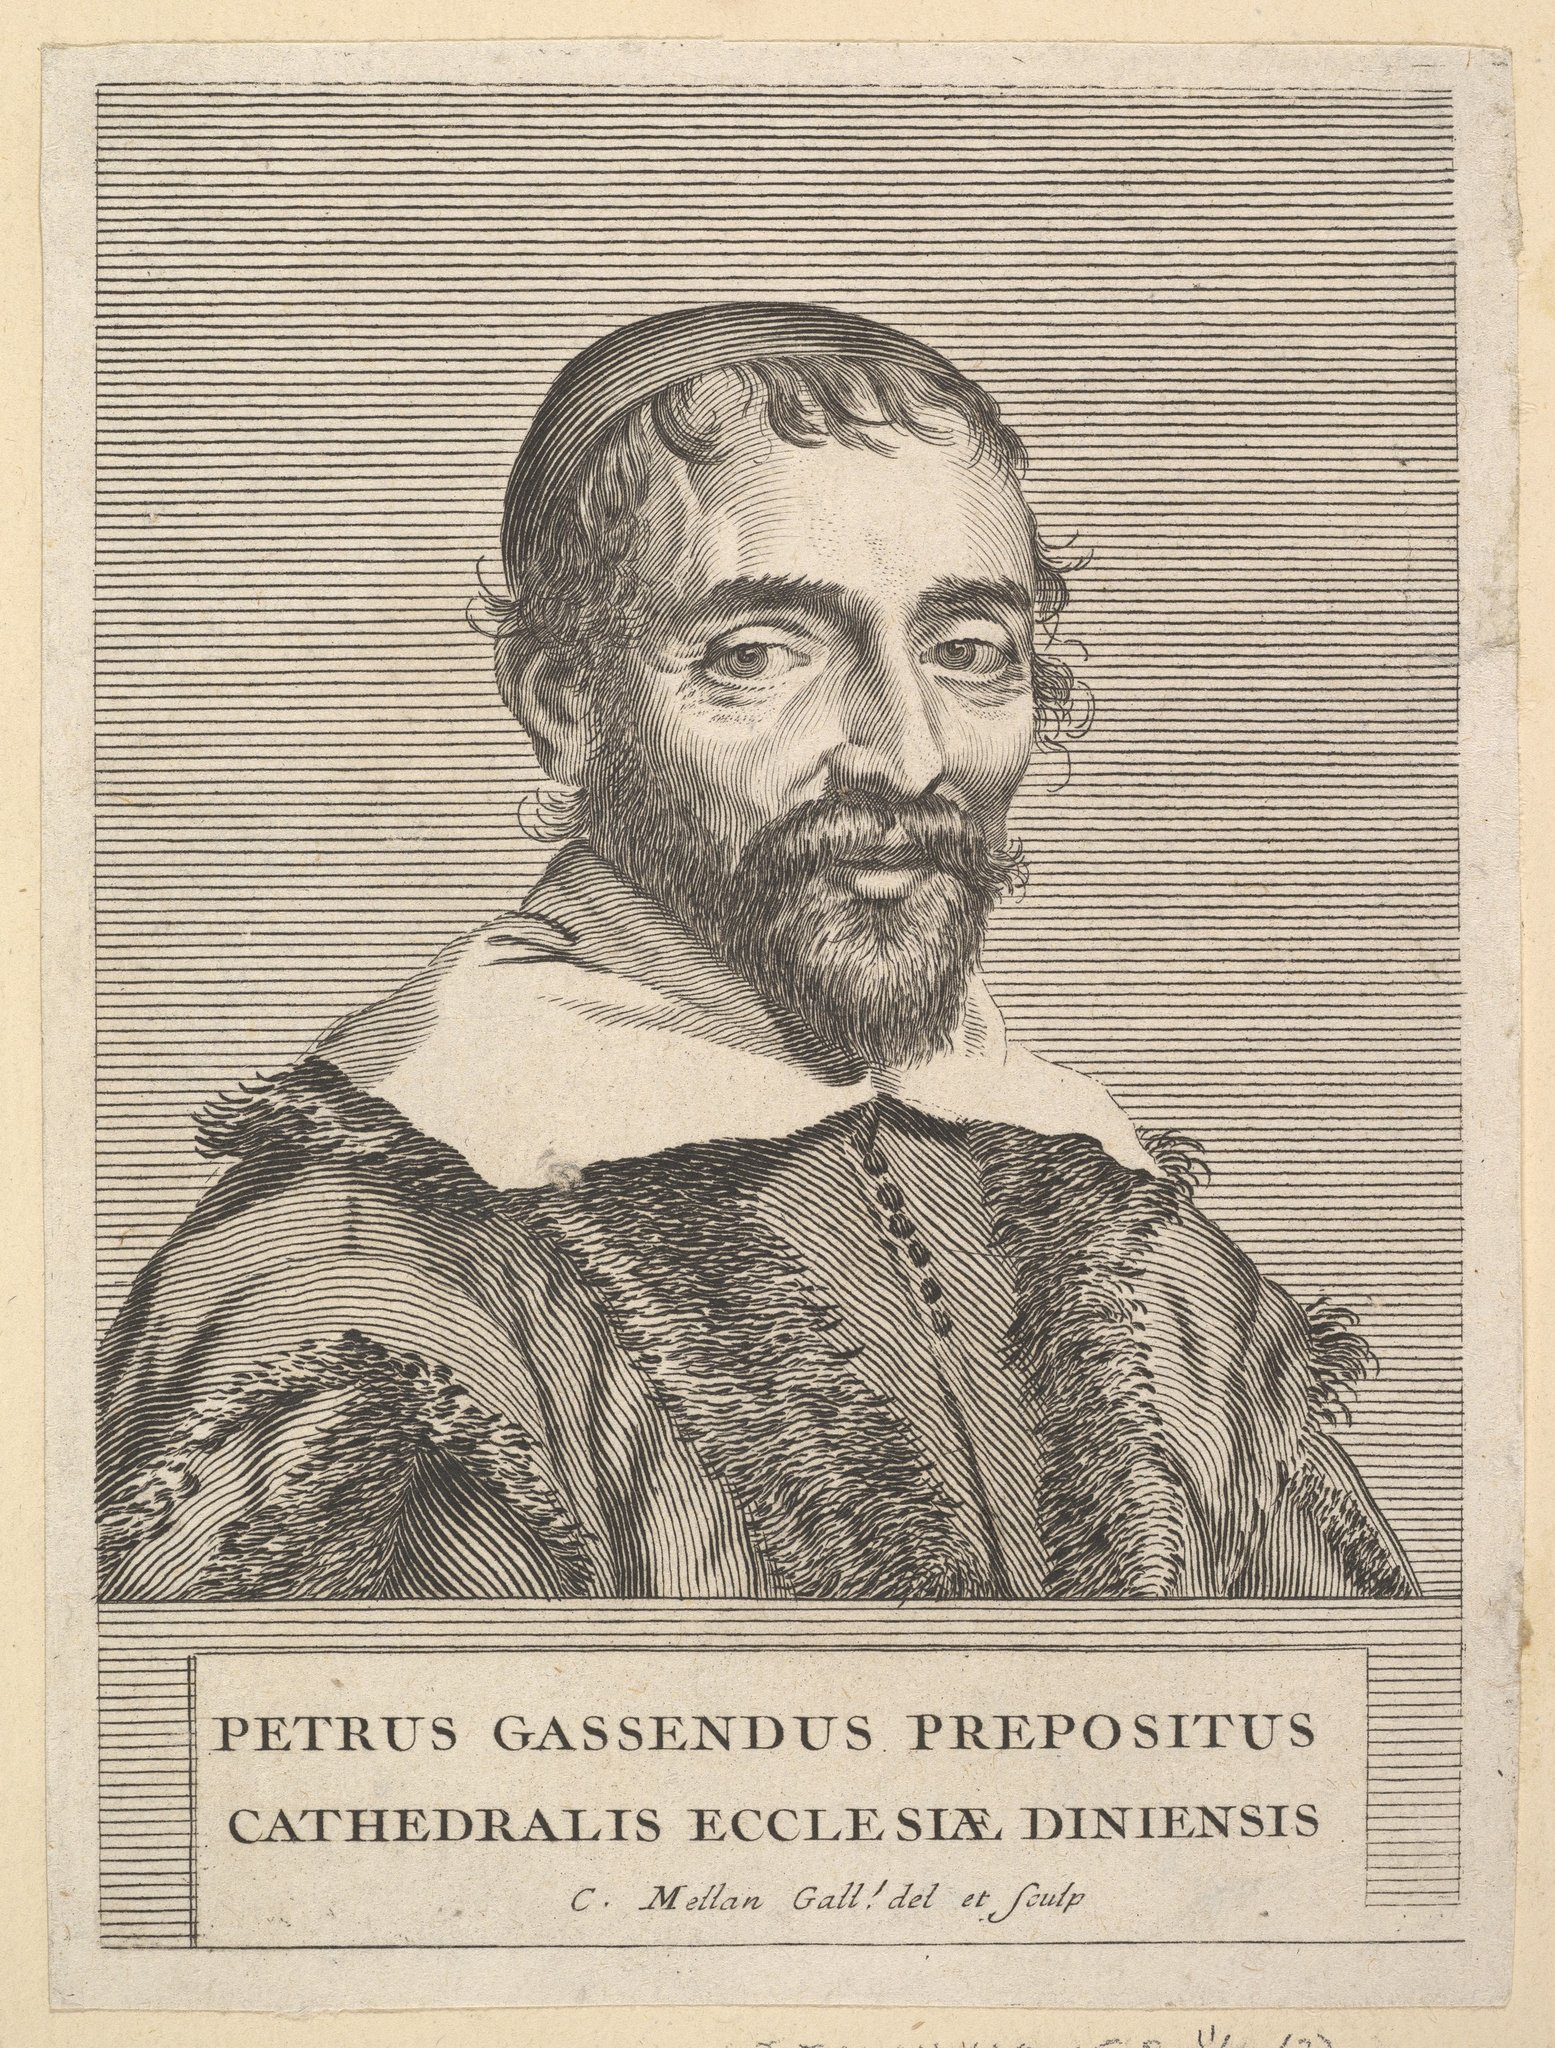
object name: print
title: Pierre Grassendi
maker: anonymous, french, 17th century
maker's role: artist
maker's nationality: french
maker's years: 1600-1700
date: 1620-1700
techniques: engraving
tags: men,portraits